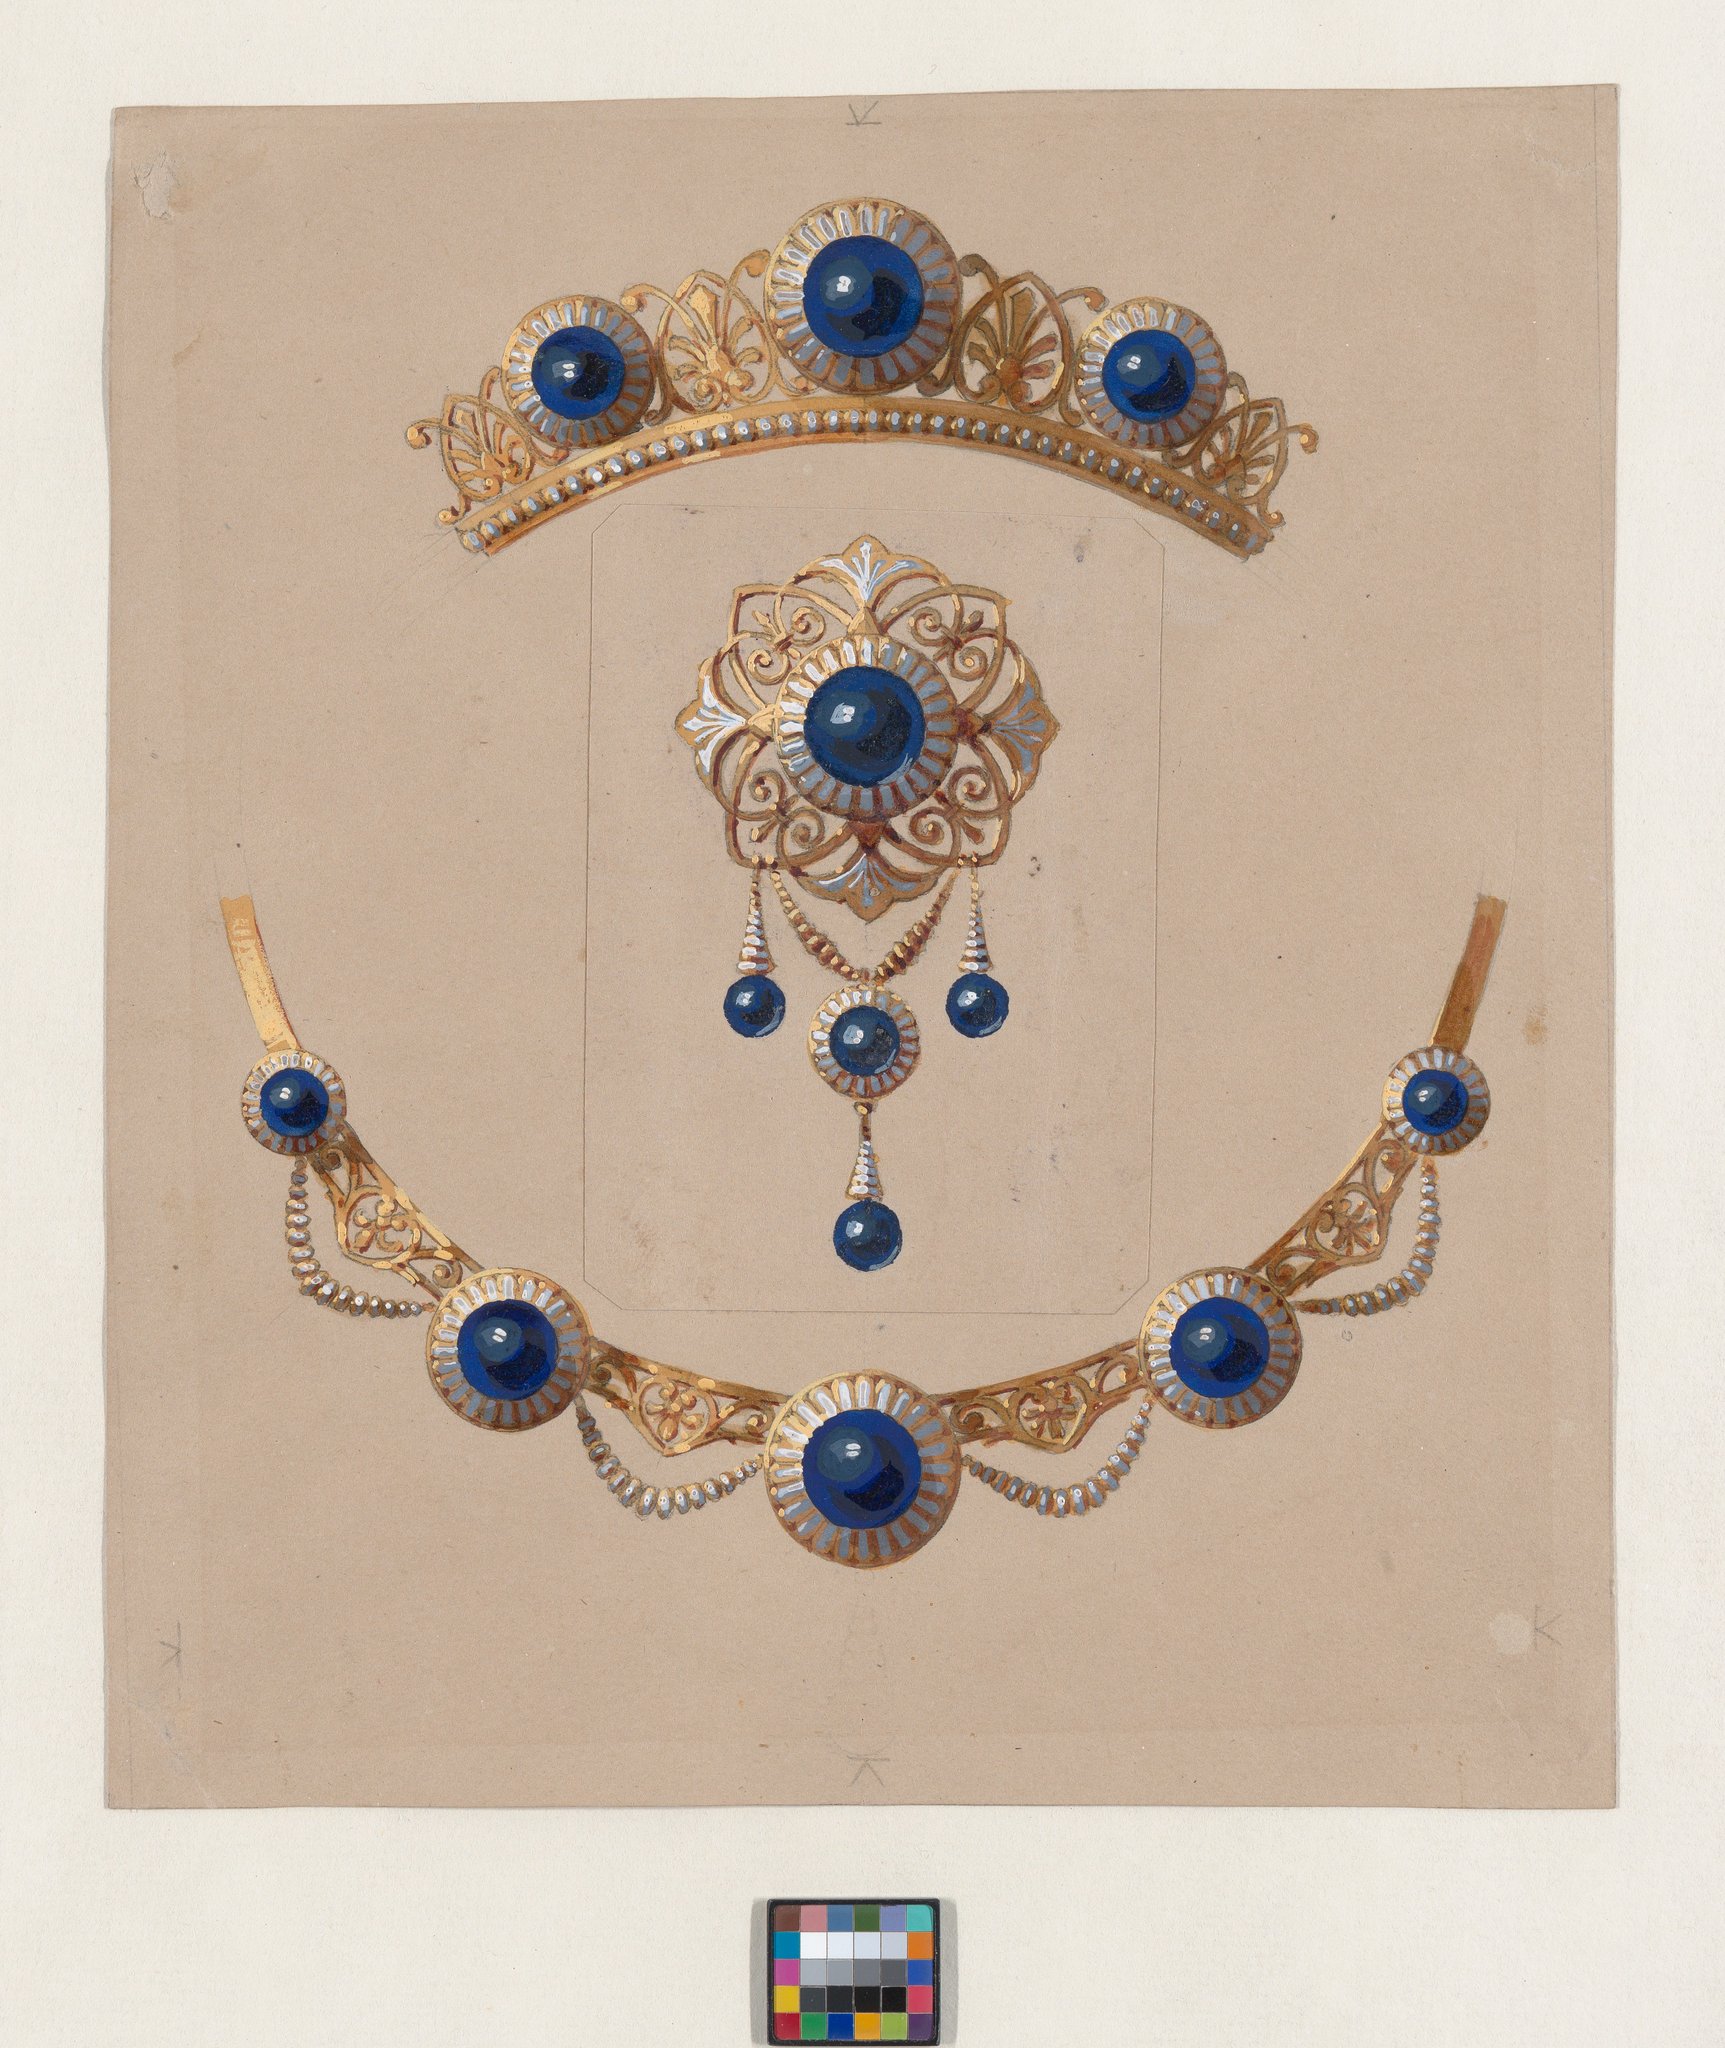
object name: album print ornament architecture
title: Parure of diadem, brooch and necklace with lapis lazuli and enamel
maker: alexis falize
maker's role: artist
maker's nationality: french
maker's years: 1811-1898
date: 1830-1870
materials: gouache, graphite, ink, paper, watercolor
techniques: pen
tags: jewelry,necklaces